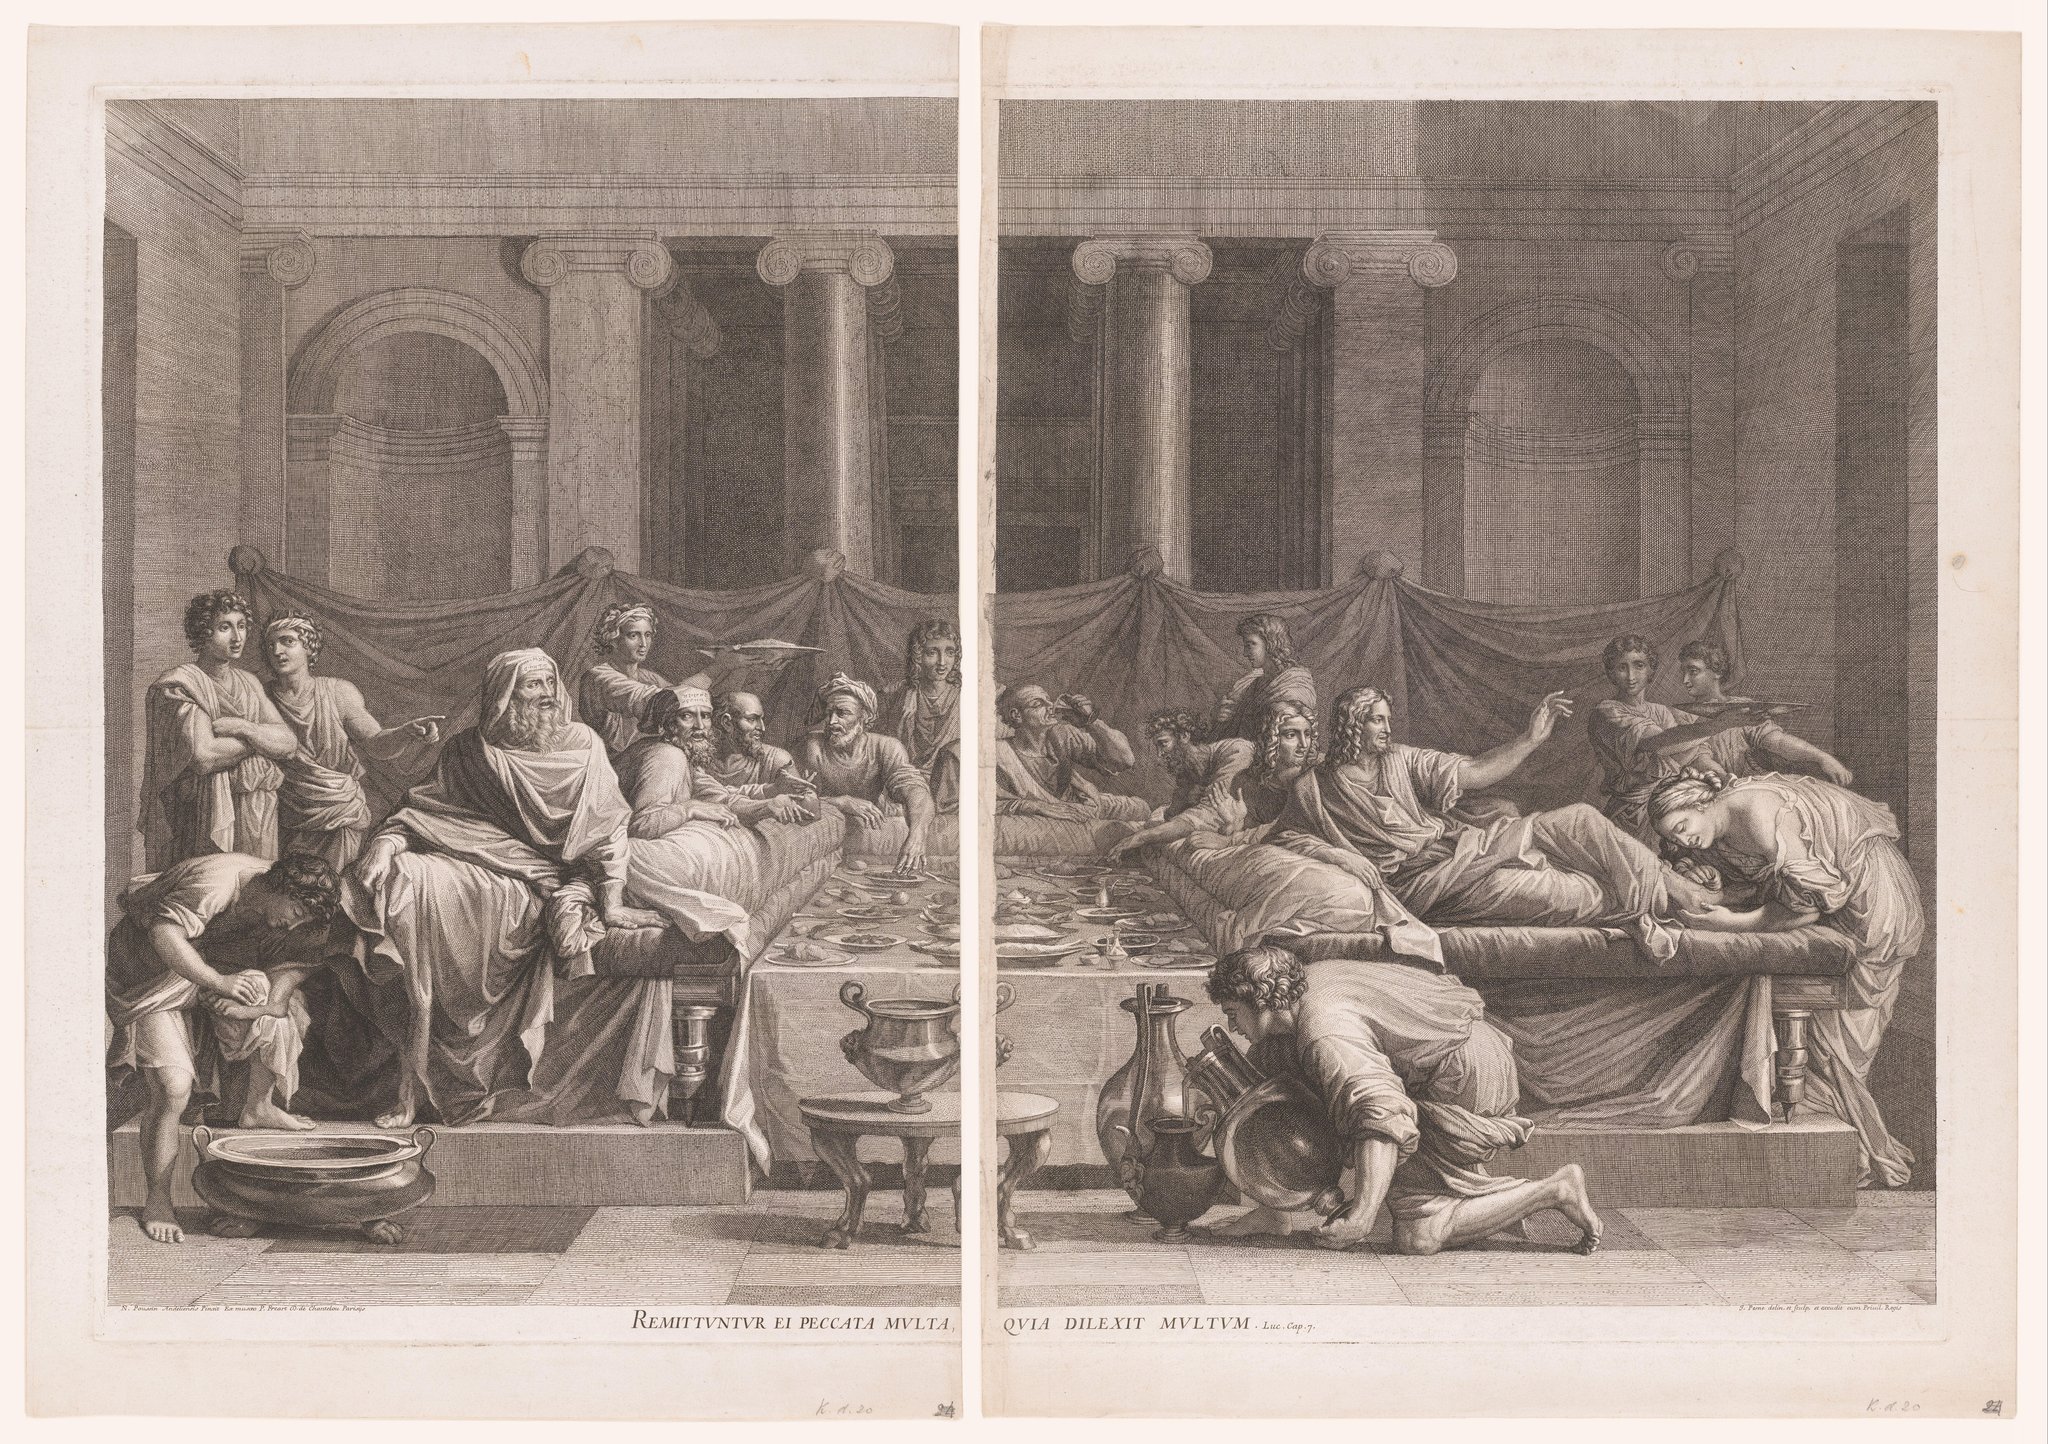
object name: print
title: Zeven sacramenten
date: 1633-1700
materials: paper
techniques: etching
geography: france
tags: meal at the house of simon the pharisee (luke 7:36-50), christ's feet are anointed by mary (magdalene), confession; 'confessione sacramentale' (ripa) ~ the third of the seven sacraments, meal in bethany (at the house of simon the leper) (matthew 26:6-13; mark 14:3-9; john 12:1-11)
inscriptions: collector's mark: Lugt 240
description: Prent maakt deel uit van een ongenummerde serie van zeven prenten. Dit object is omwille van een betere presentatie virtueel samengevoegd, maar bestaat fysiek uit losse onderdelen.